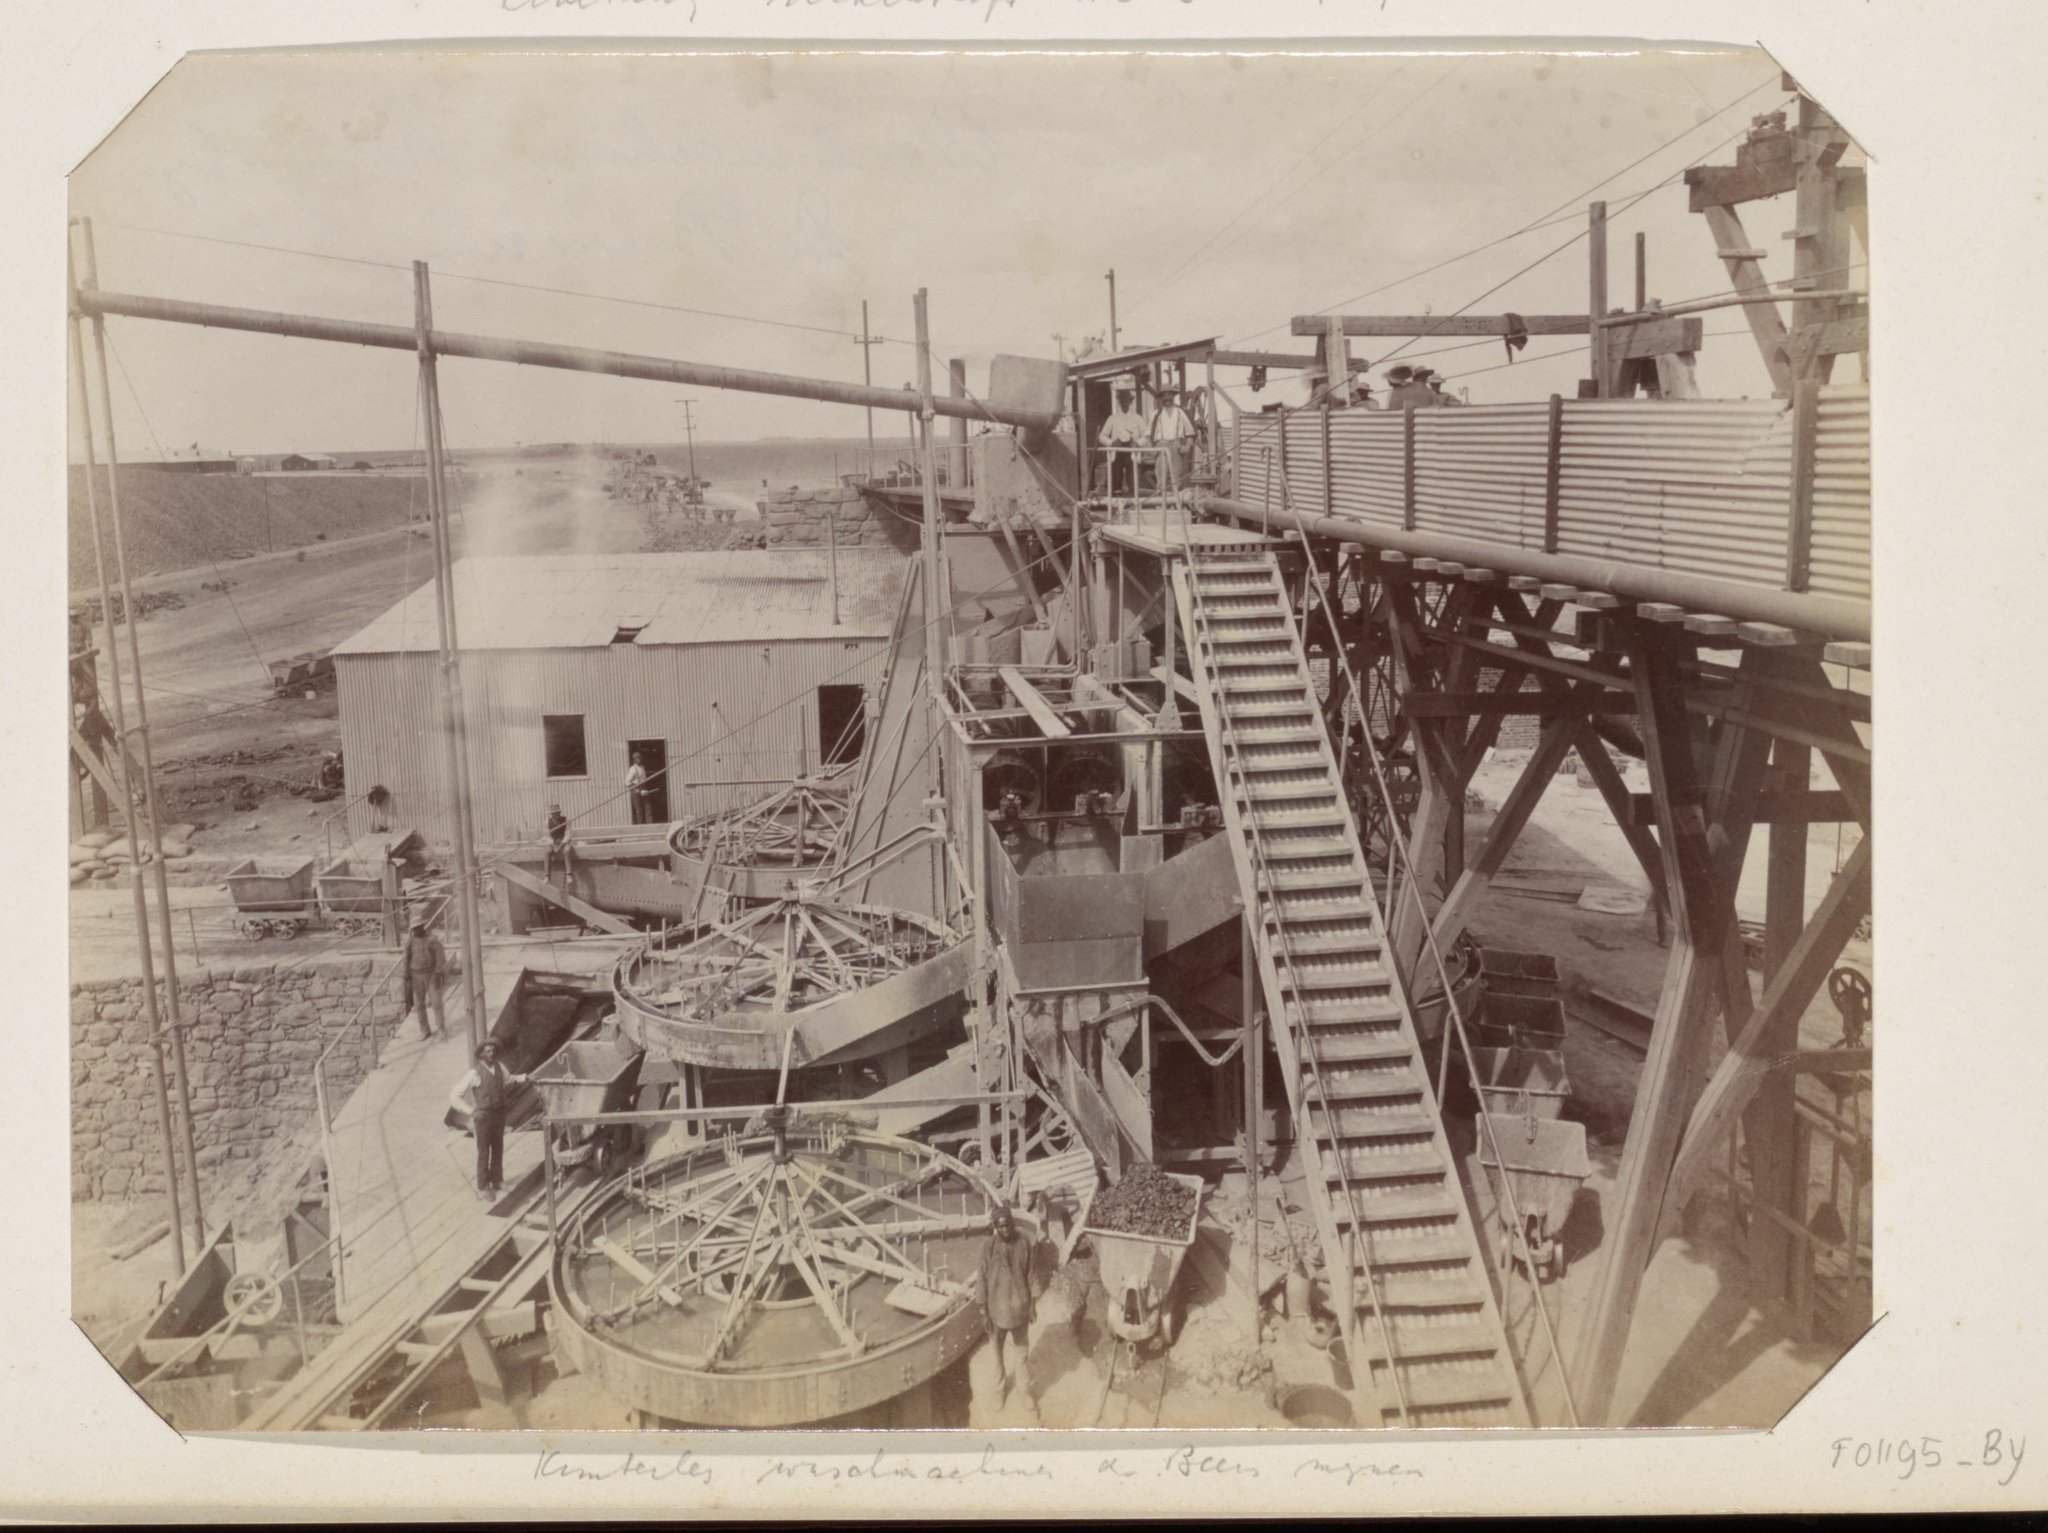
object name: photograph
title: Arbeiders aan het werk bij de wasmachine van de De Beersmijnen in Kimberley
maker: Anonymous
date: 1860-1910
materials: cardboard, paper, photographic support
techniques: albumen print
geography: kimberley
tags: mine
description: Onderdeel van Fotoalbum van een reis door de Verenigde Staten, Honolulu, Nederlands-Indië, Aden, Zanzibar en Zuidelijk Afrika.